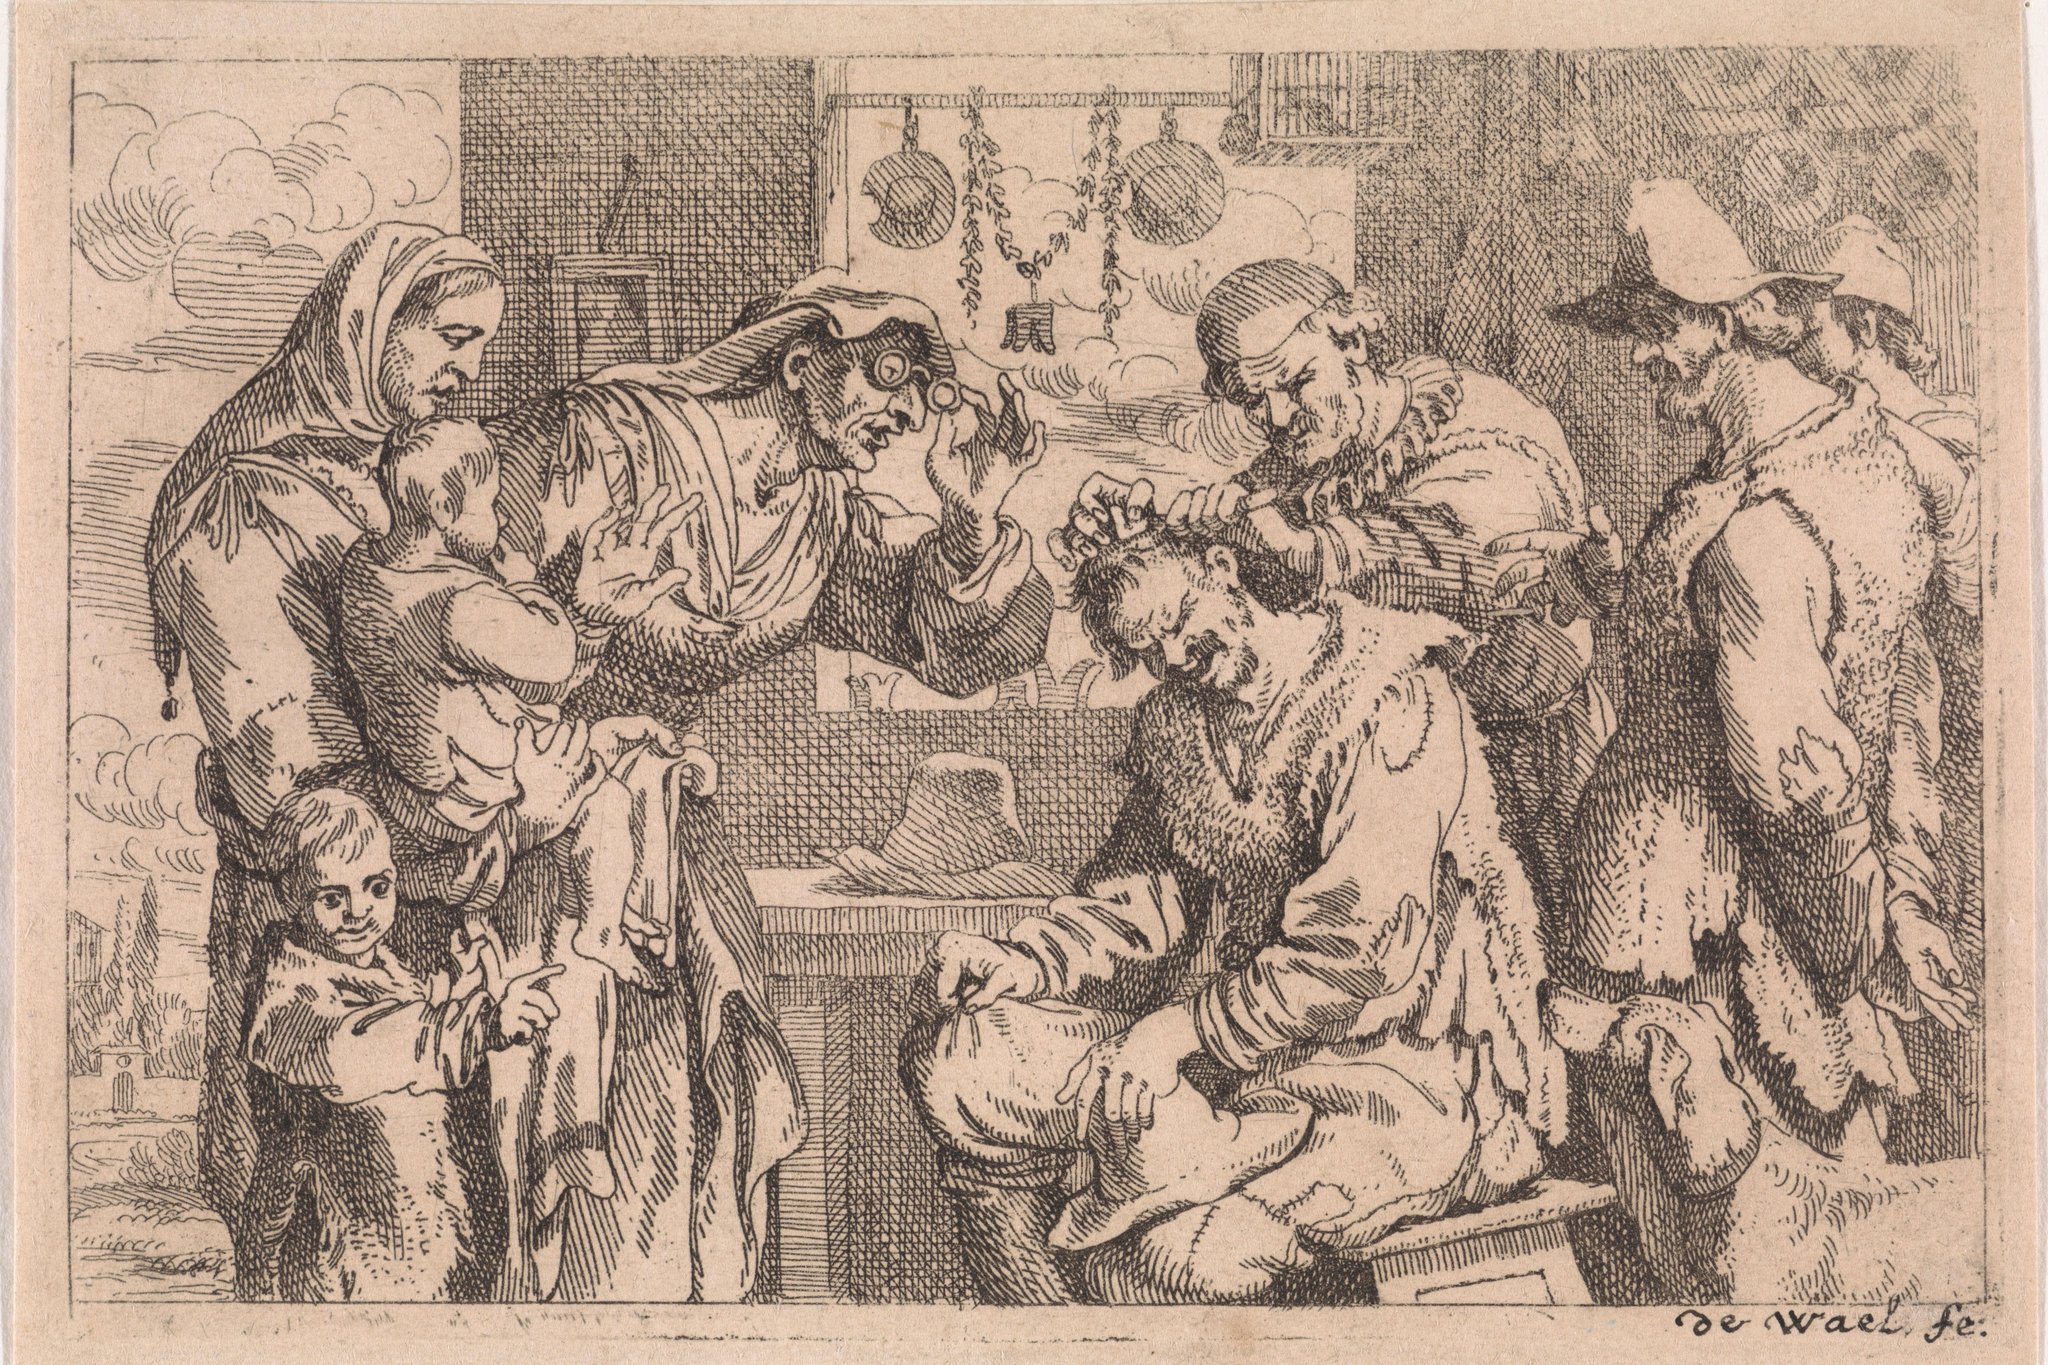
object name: print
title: Diverse genretaferelen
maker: jan baptist de wael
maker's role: print maker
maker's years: 1632-1669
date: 1642-1669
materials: paper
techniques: etching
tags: barber; surgeon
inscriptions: collector's mark: Lugt 2228, inscription: ‘de Wael fe.’, collector's mark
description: Een chirurgijn maakt een insnijding in het hoofd van een man die voor hem zit. Omstanders kijken toe.